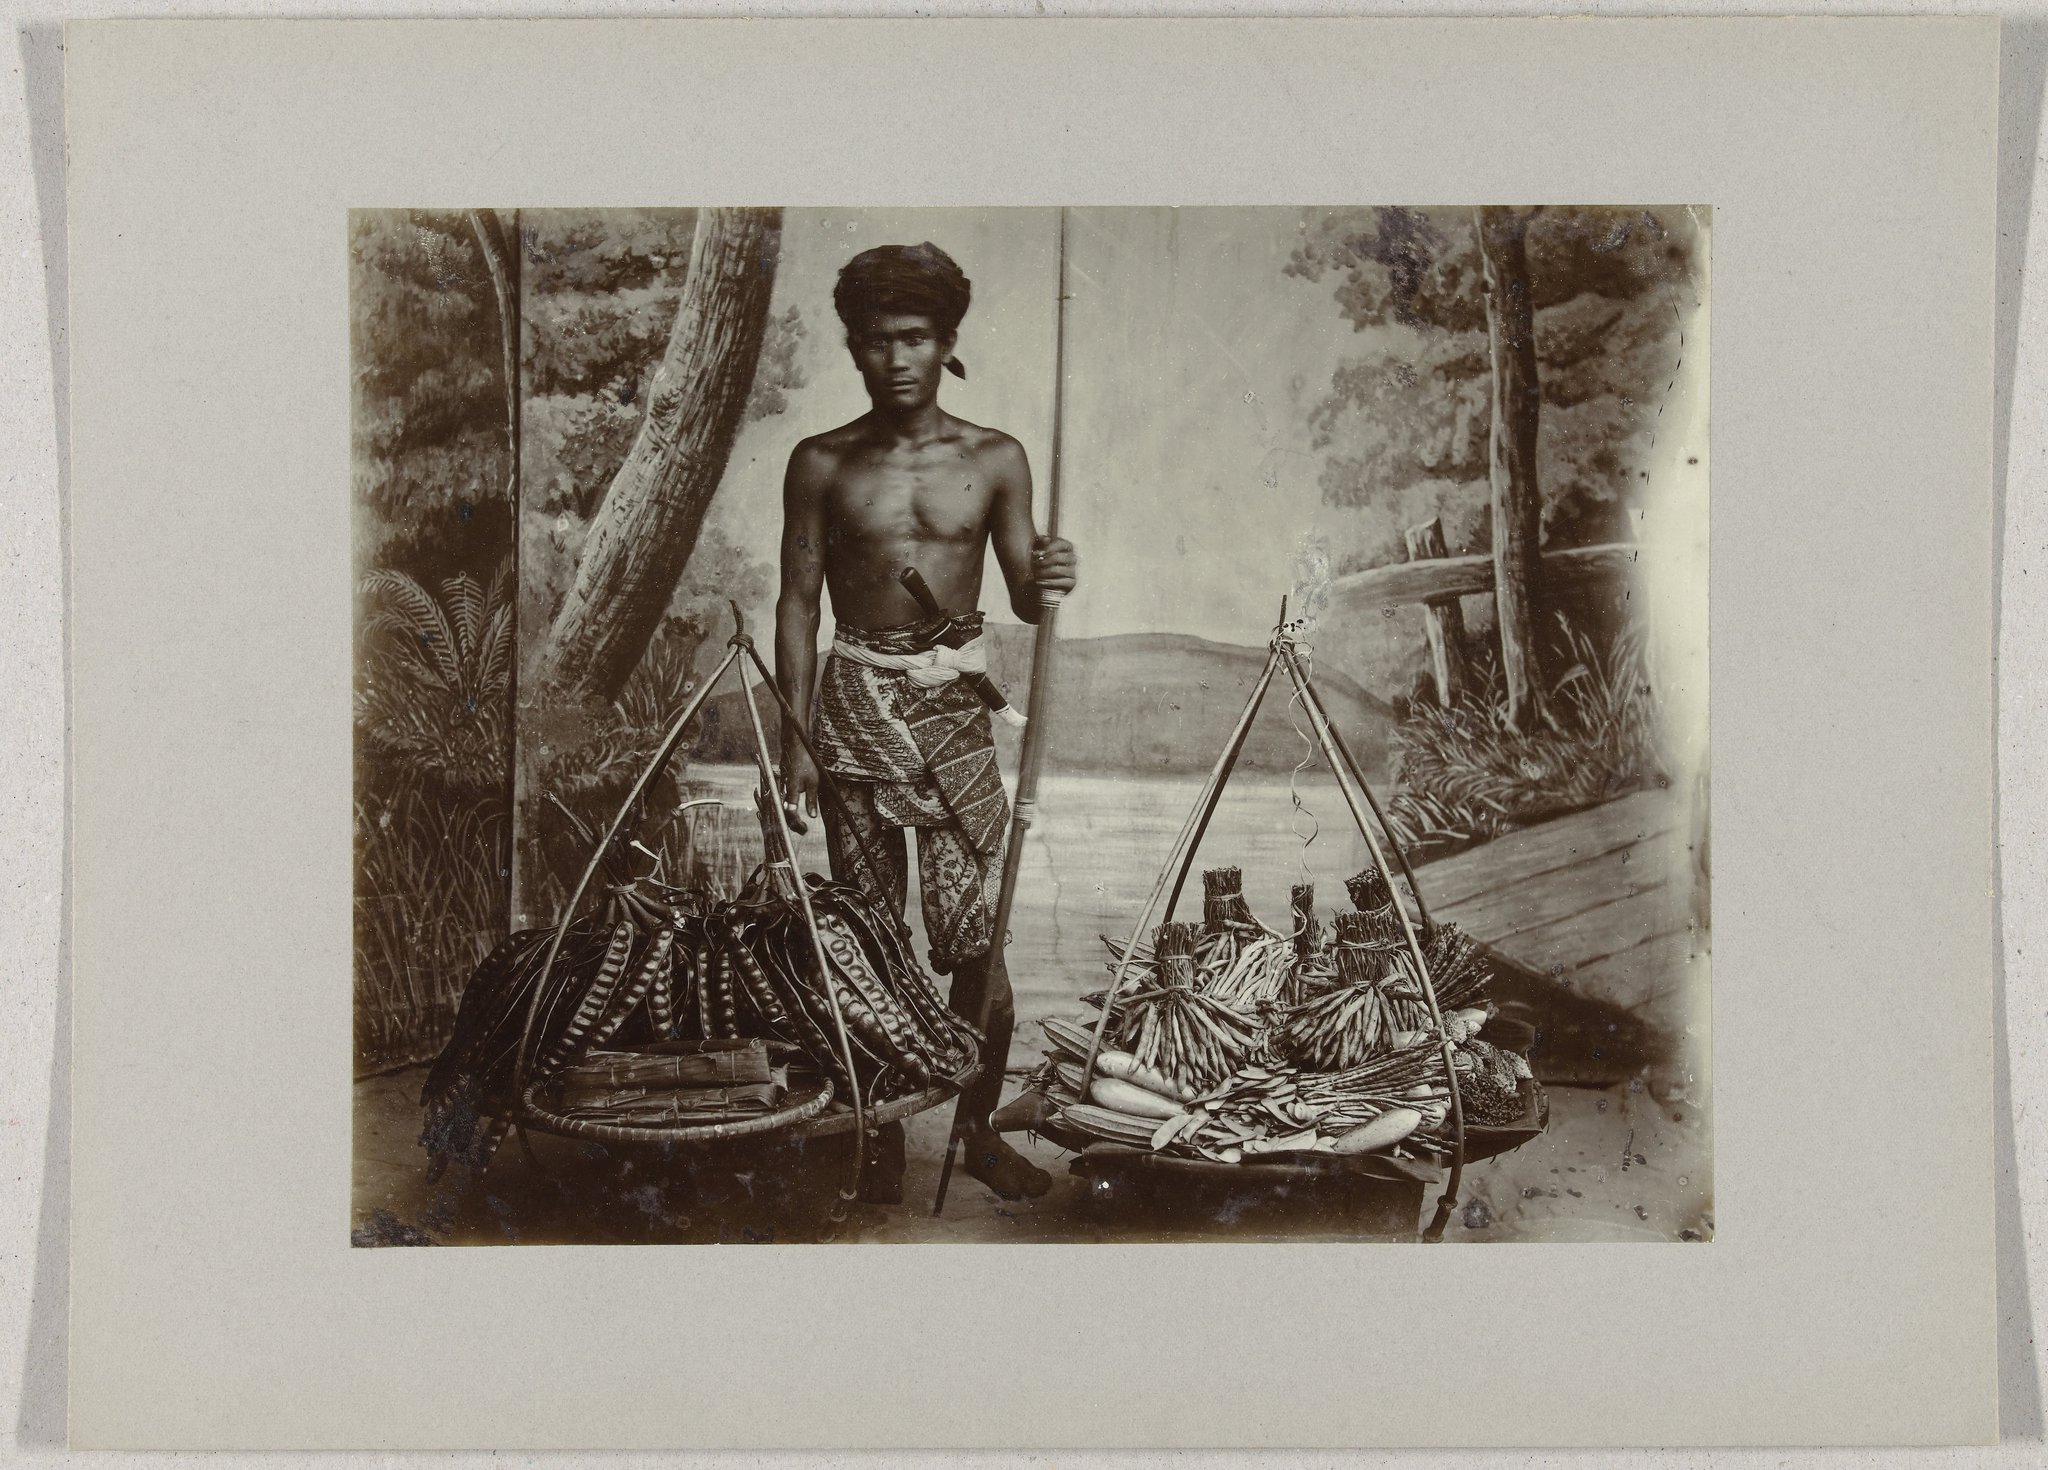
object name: photograph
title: Studioportret van een straatverkoper in Nederlands-Indië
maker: Anonymous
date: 1895-1915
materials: cardboard, paper, photographic support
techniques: gelatin silver print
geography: dutch east indies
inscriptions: number: ‘16’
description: Straatverkoper voor een geschilderd decor, Nederlands-Indië